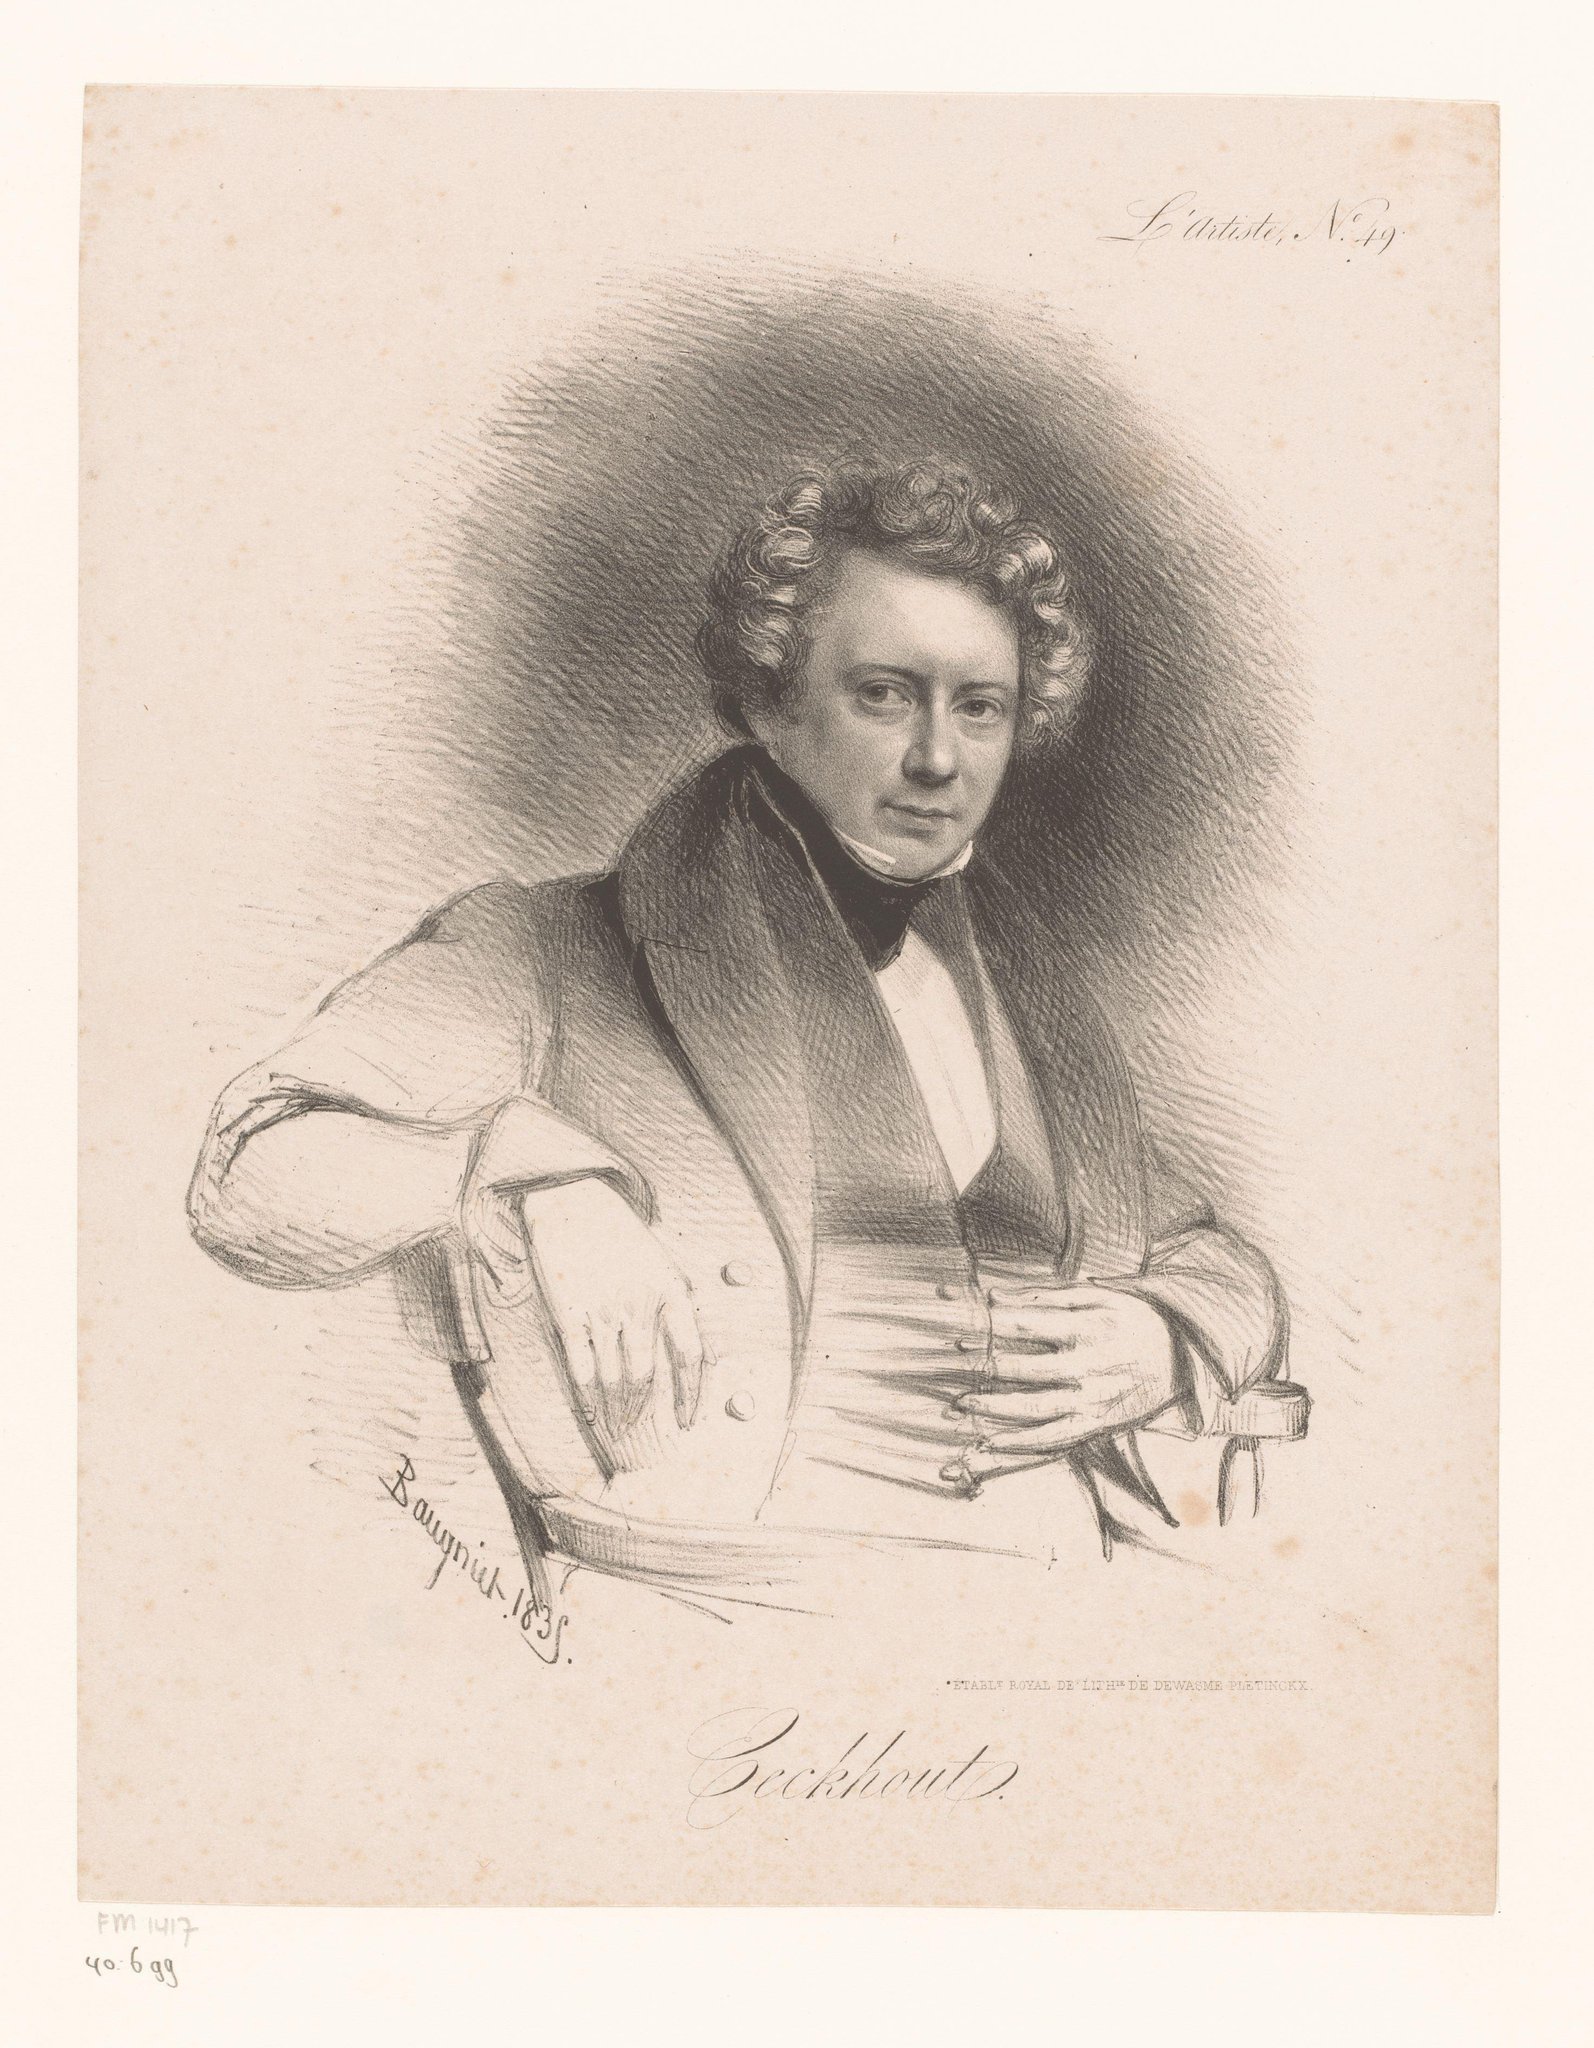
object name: print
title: Eeckhout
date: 1839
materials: paper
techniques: lithograph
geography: brussels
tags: antwerp, paris, draughtsman, jacob joseph eeckhout, sitting figure, adult man, historical persons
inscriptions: collector's mark: Lugt 2760, collector's mark: Lugt 2228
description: Prent uit: L'Artiste [1833-...], nr. 49.